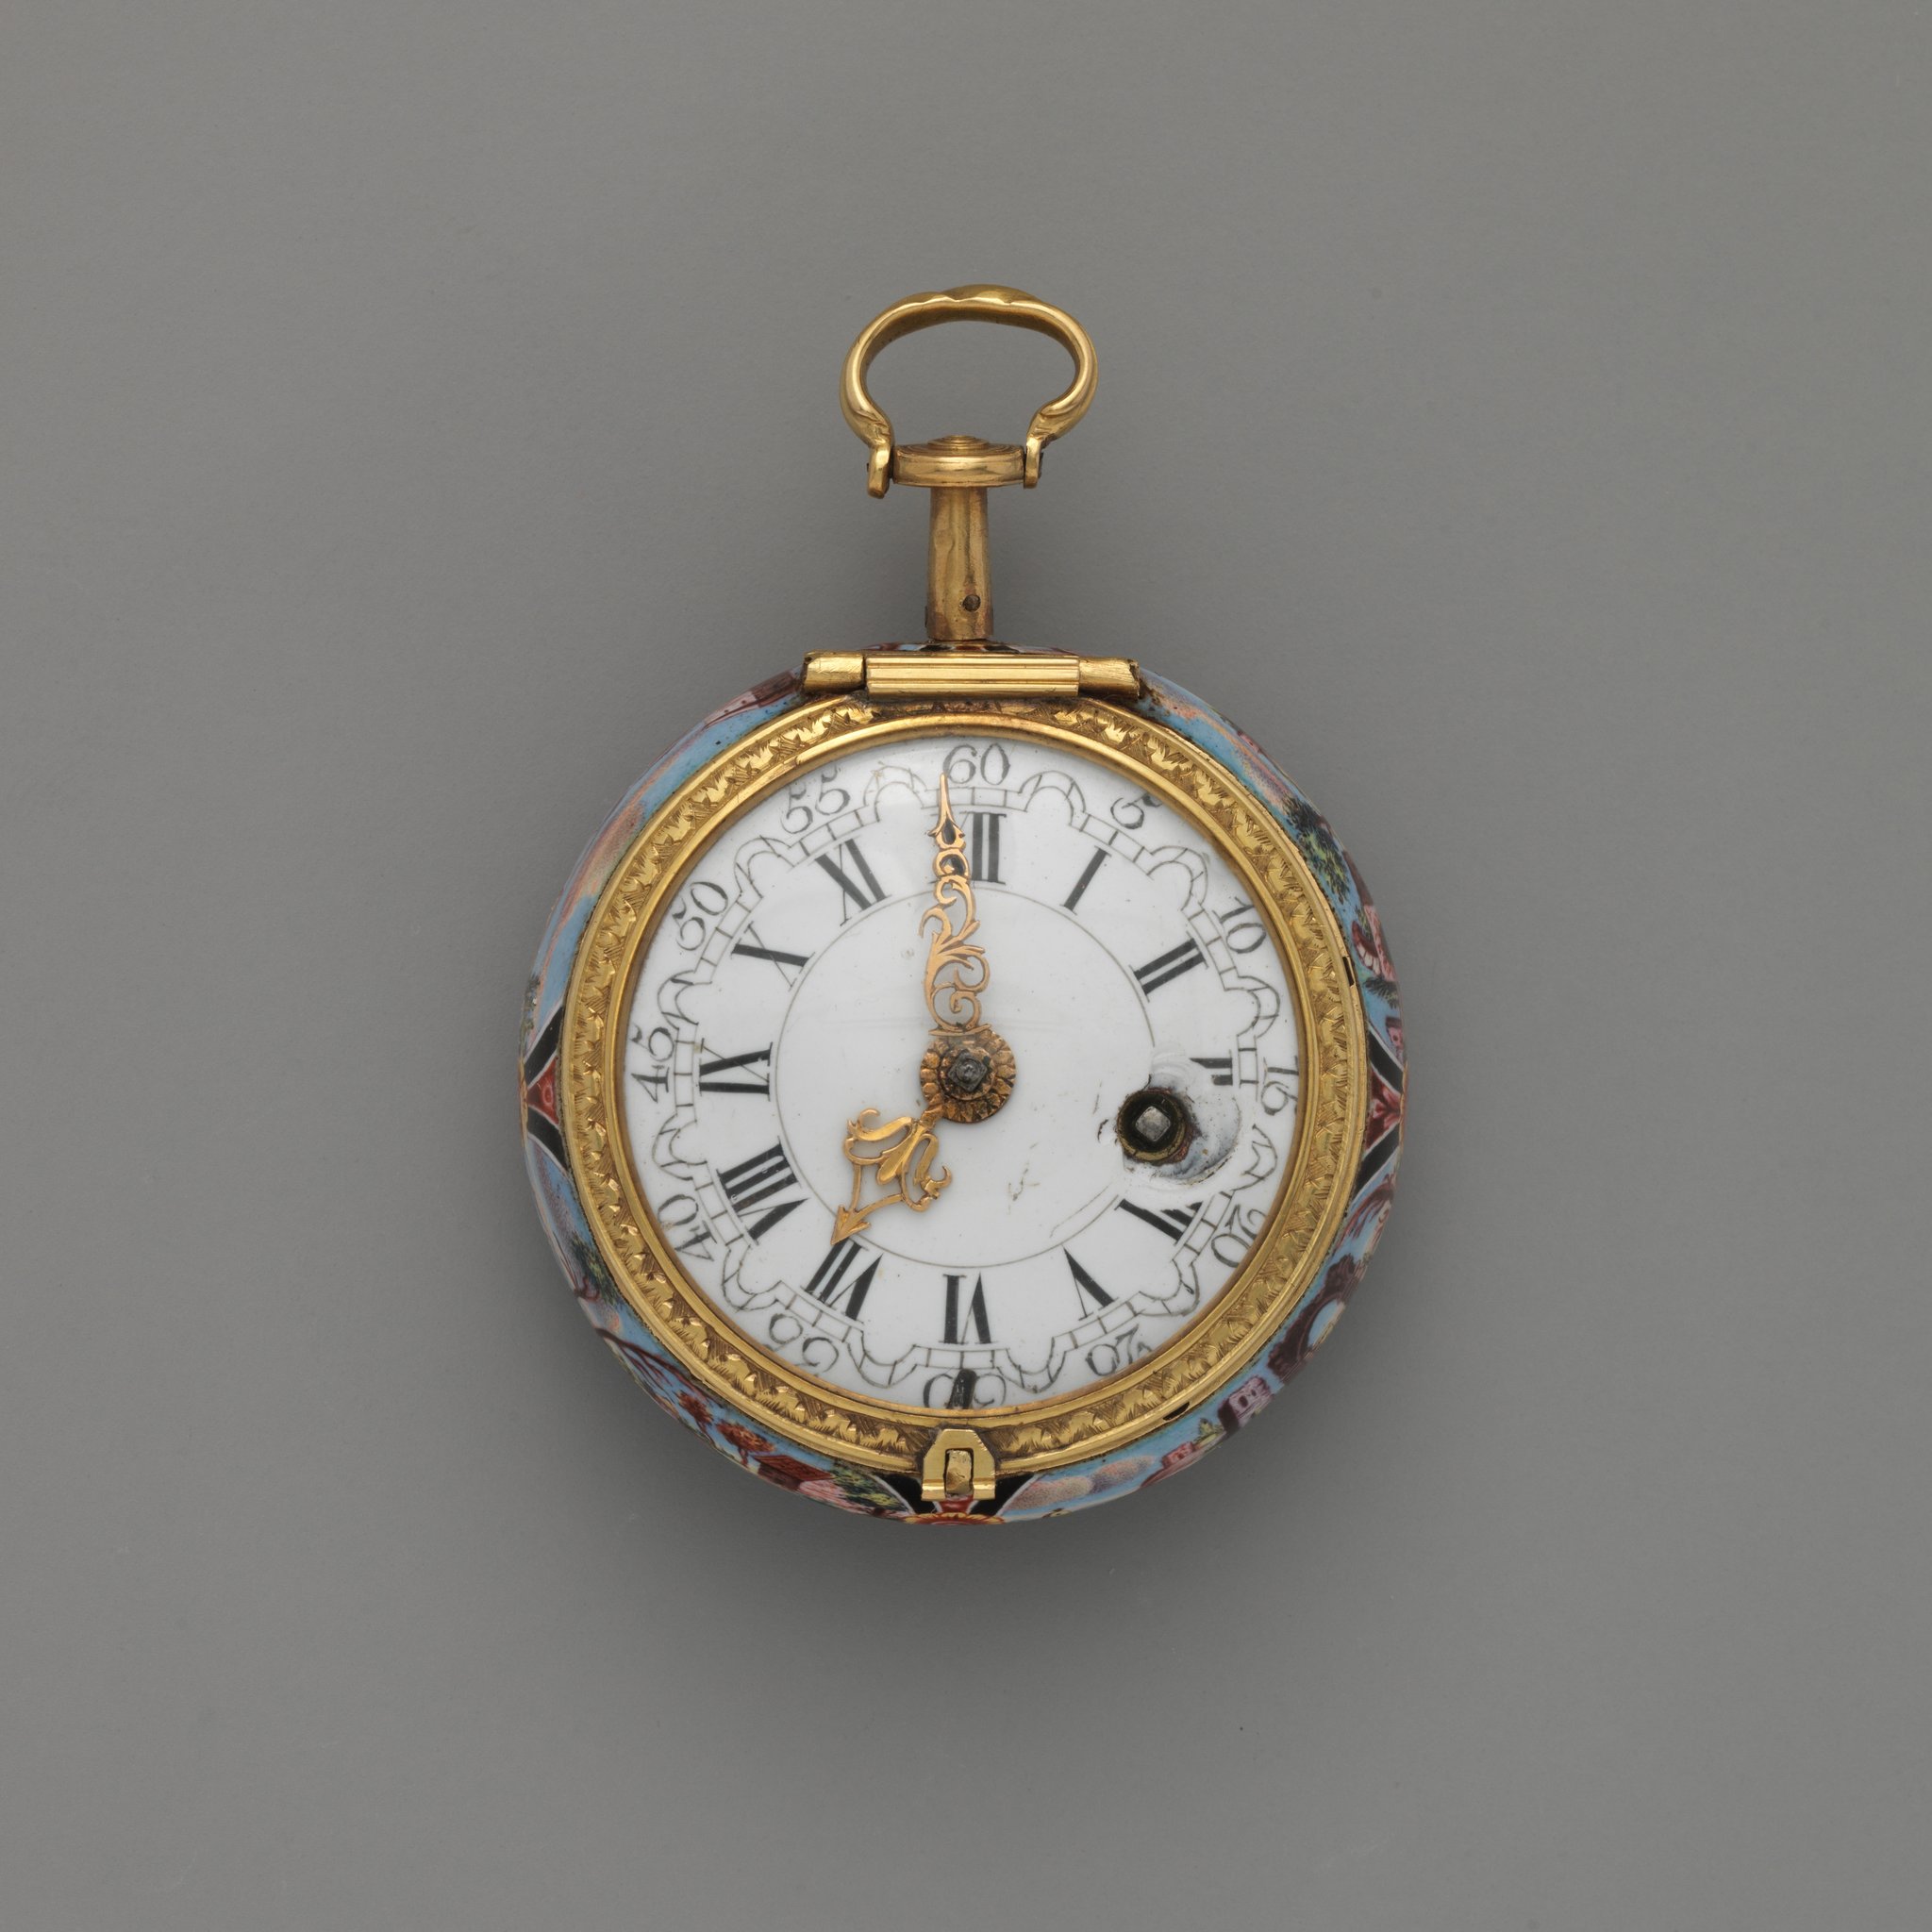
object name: watch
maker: charles cabrier ii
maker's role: maker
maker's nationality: british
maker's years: 1719-1776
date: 1740-1760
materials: enamel, silver